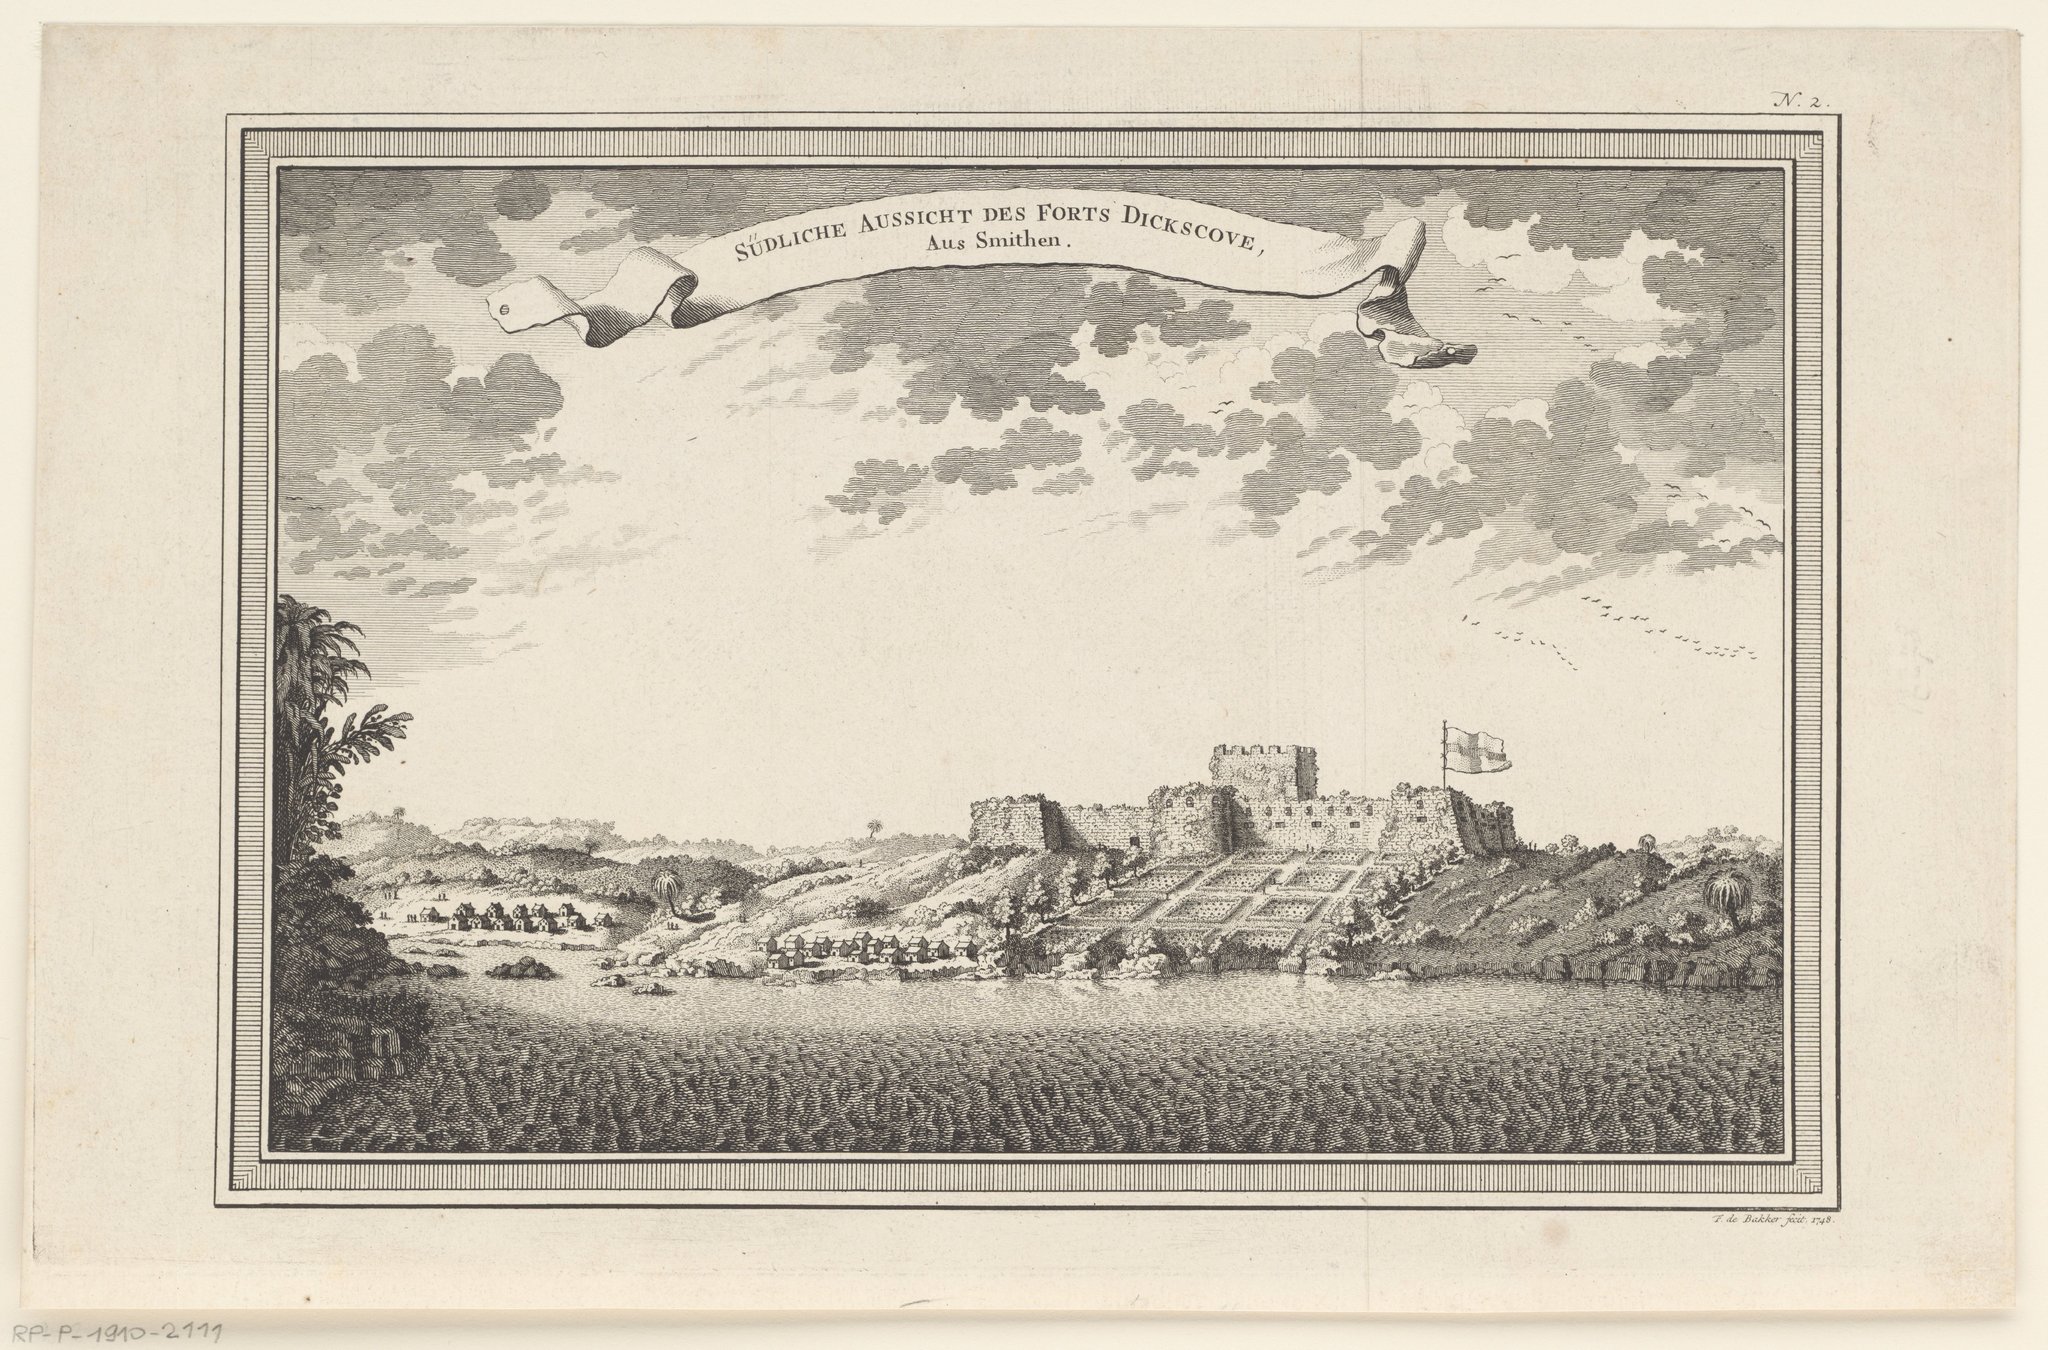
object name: print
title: Südliche Aussicht des Forts Dickscove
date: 1748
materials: paper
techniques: etching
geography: amsterdam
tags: fortress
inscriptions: collector's mark: Lugt 2228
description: Gezicht op Fort Dixcove en de aan de hang gelegene tuinen vanuit de overkant van een water. Op het fort is de Engelse vlag gehesen.